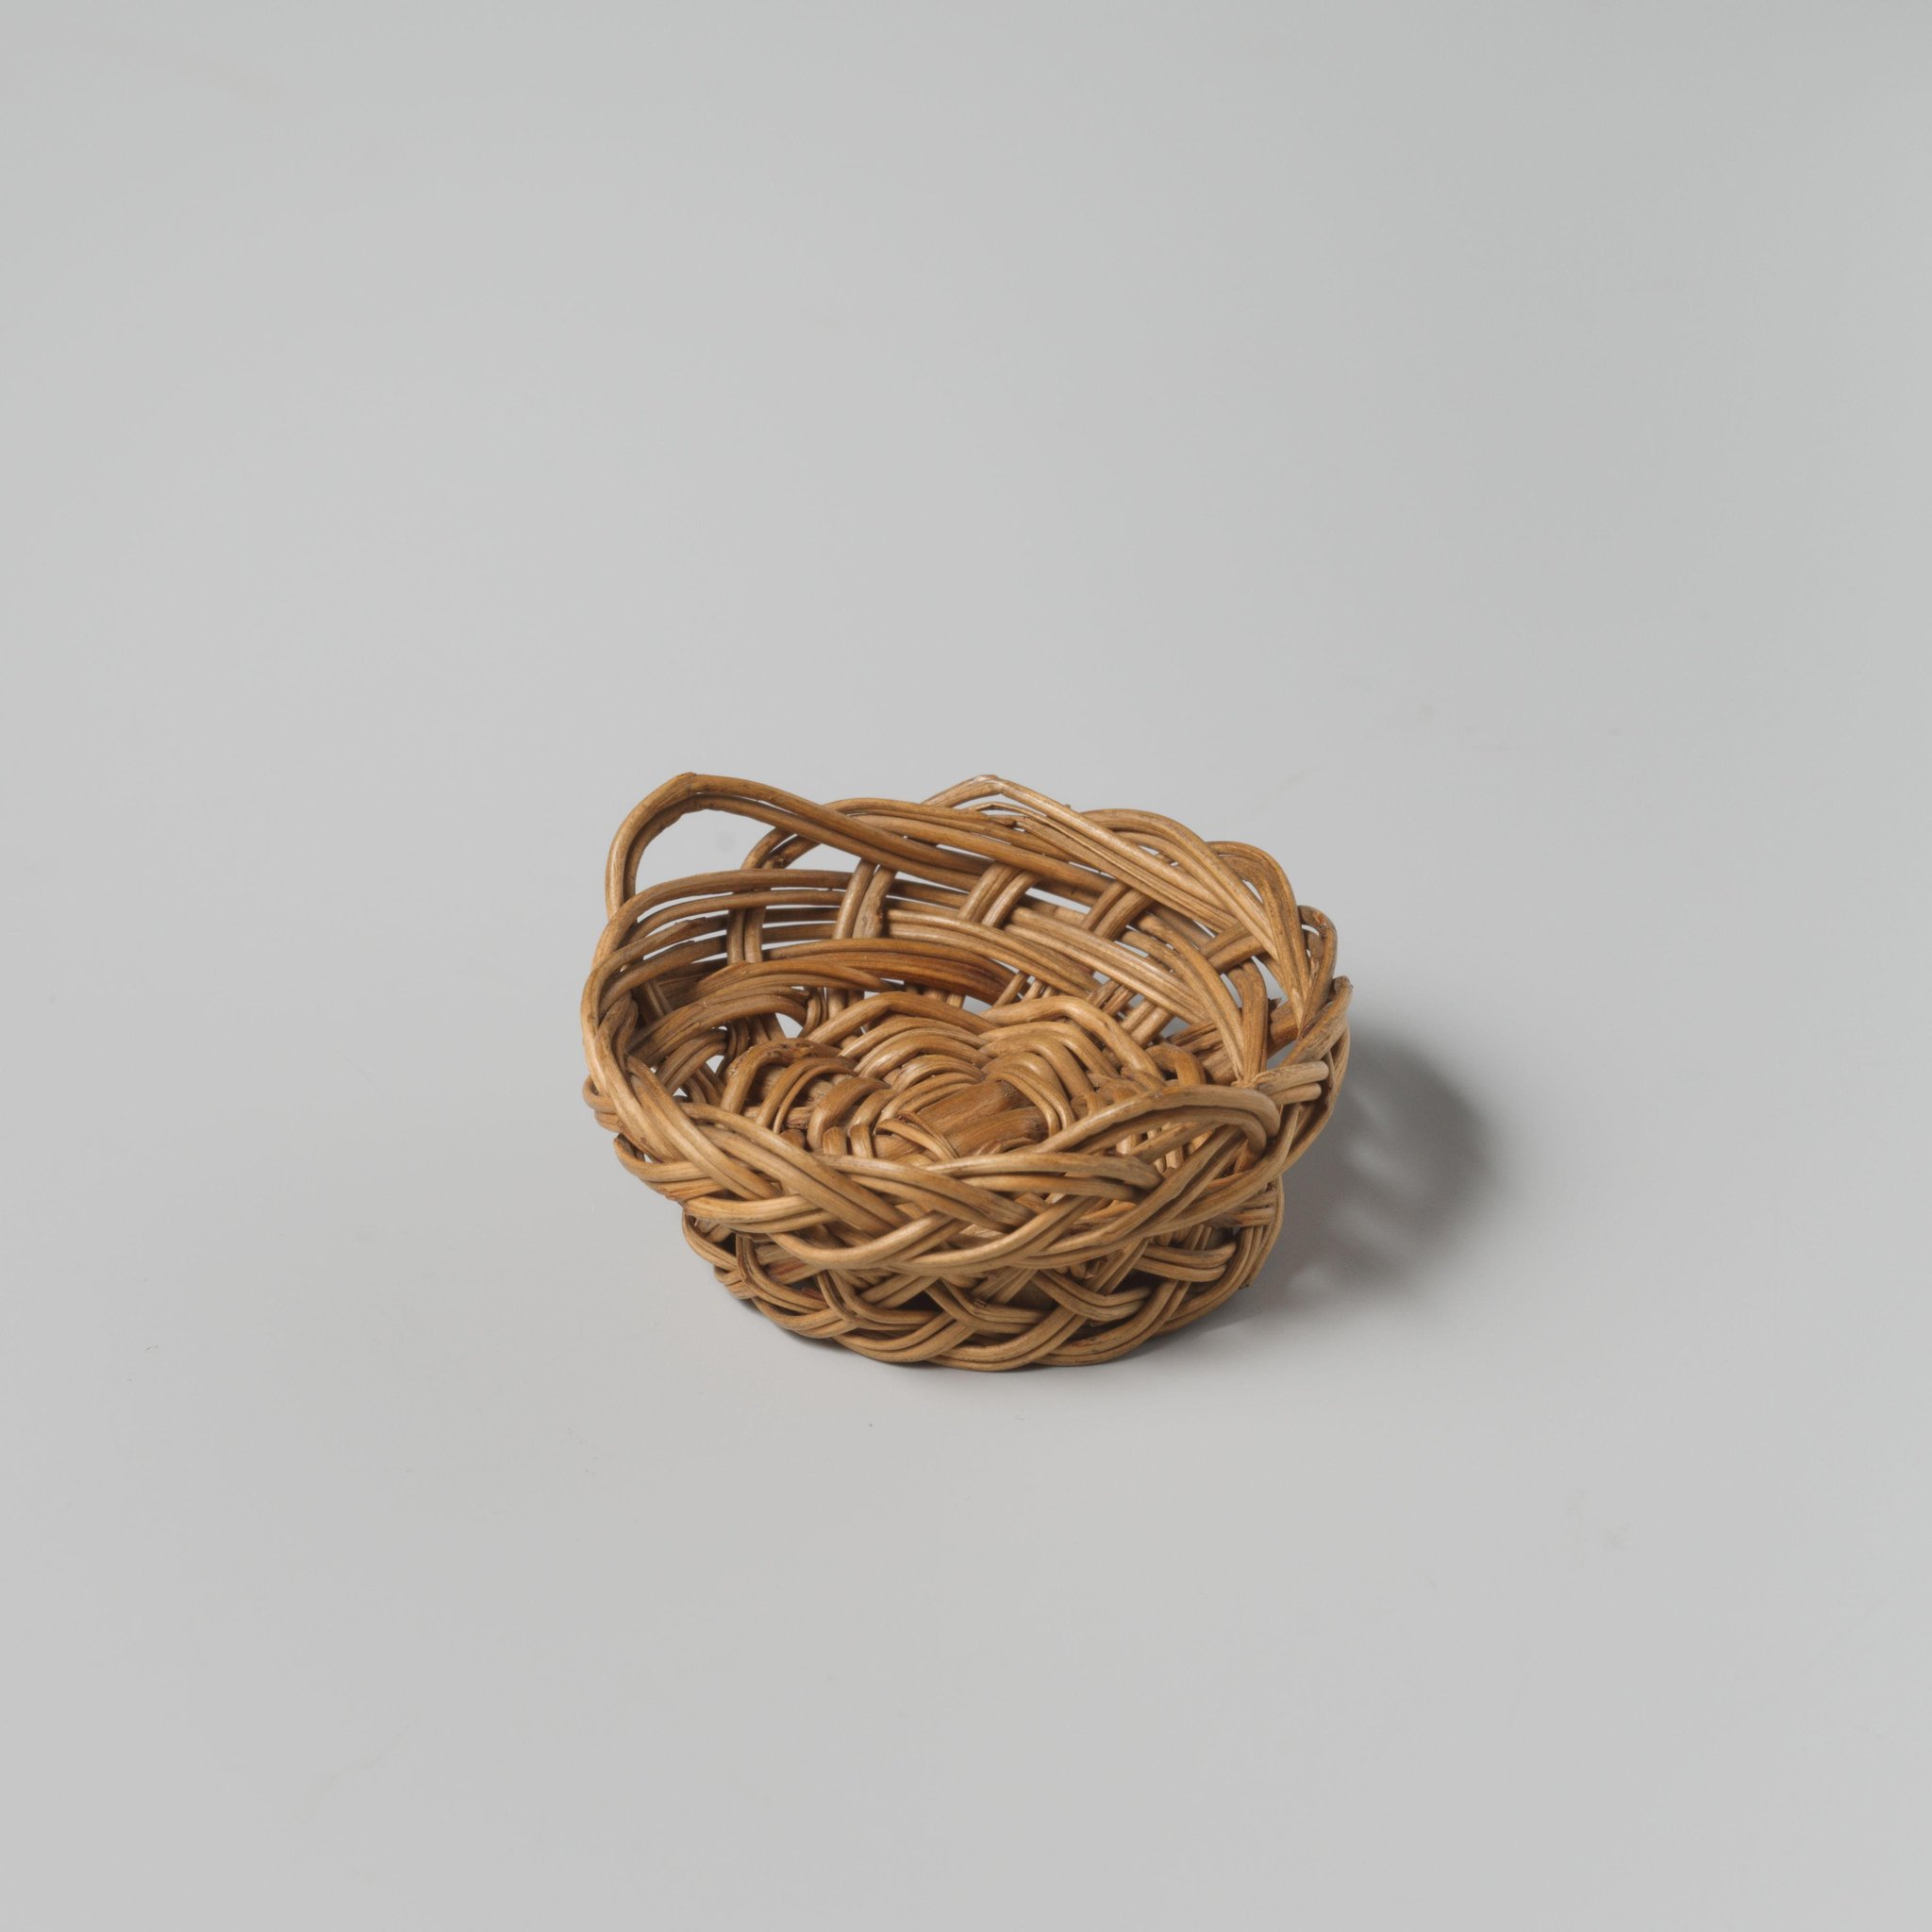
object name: miniature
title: Broodmand van ronde wilgenteen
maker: Anonymous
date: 1675-1699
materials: plant material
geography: amsterdam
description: Broodmand van ronde wilgenteen, uitgevoerd in zogenaamd open, 'getrokken', vlechtwerk. De mand heeft twee handvatten.